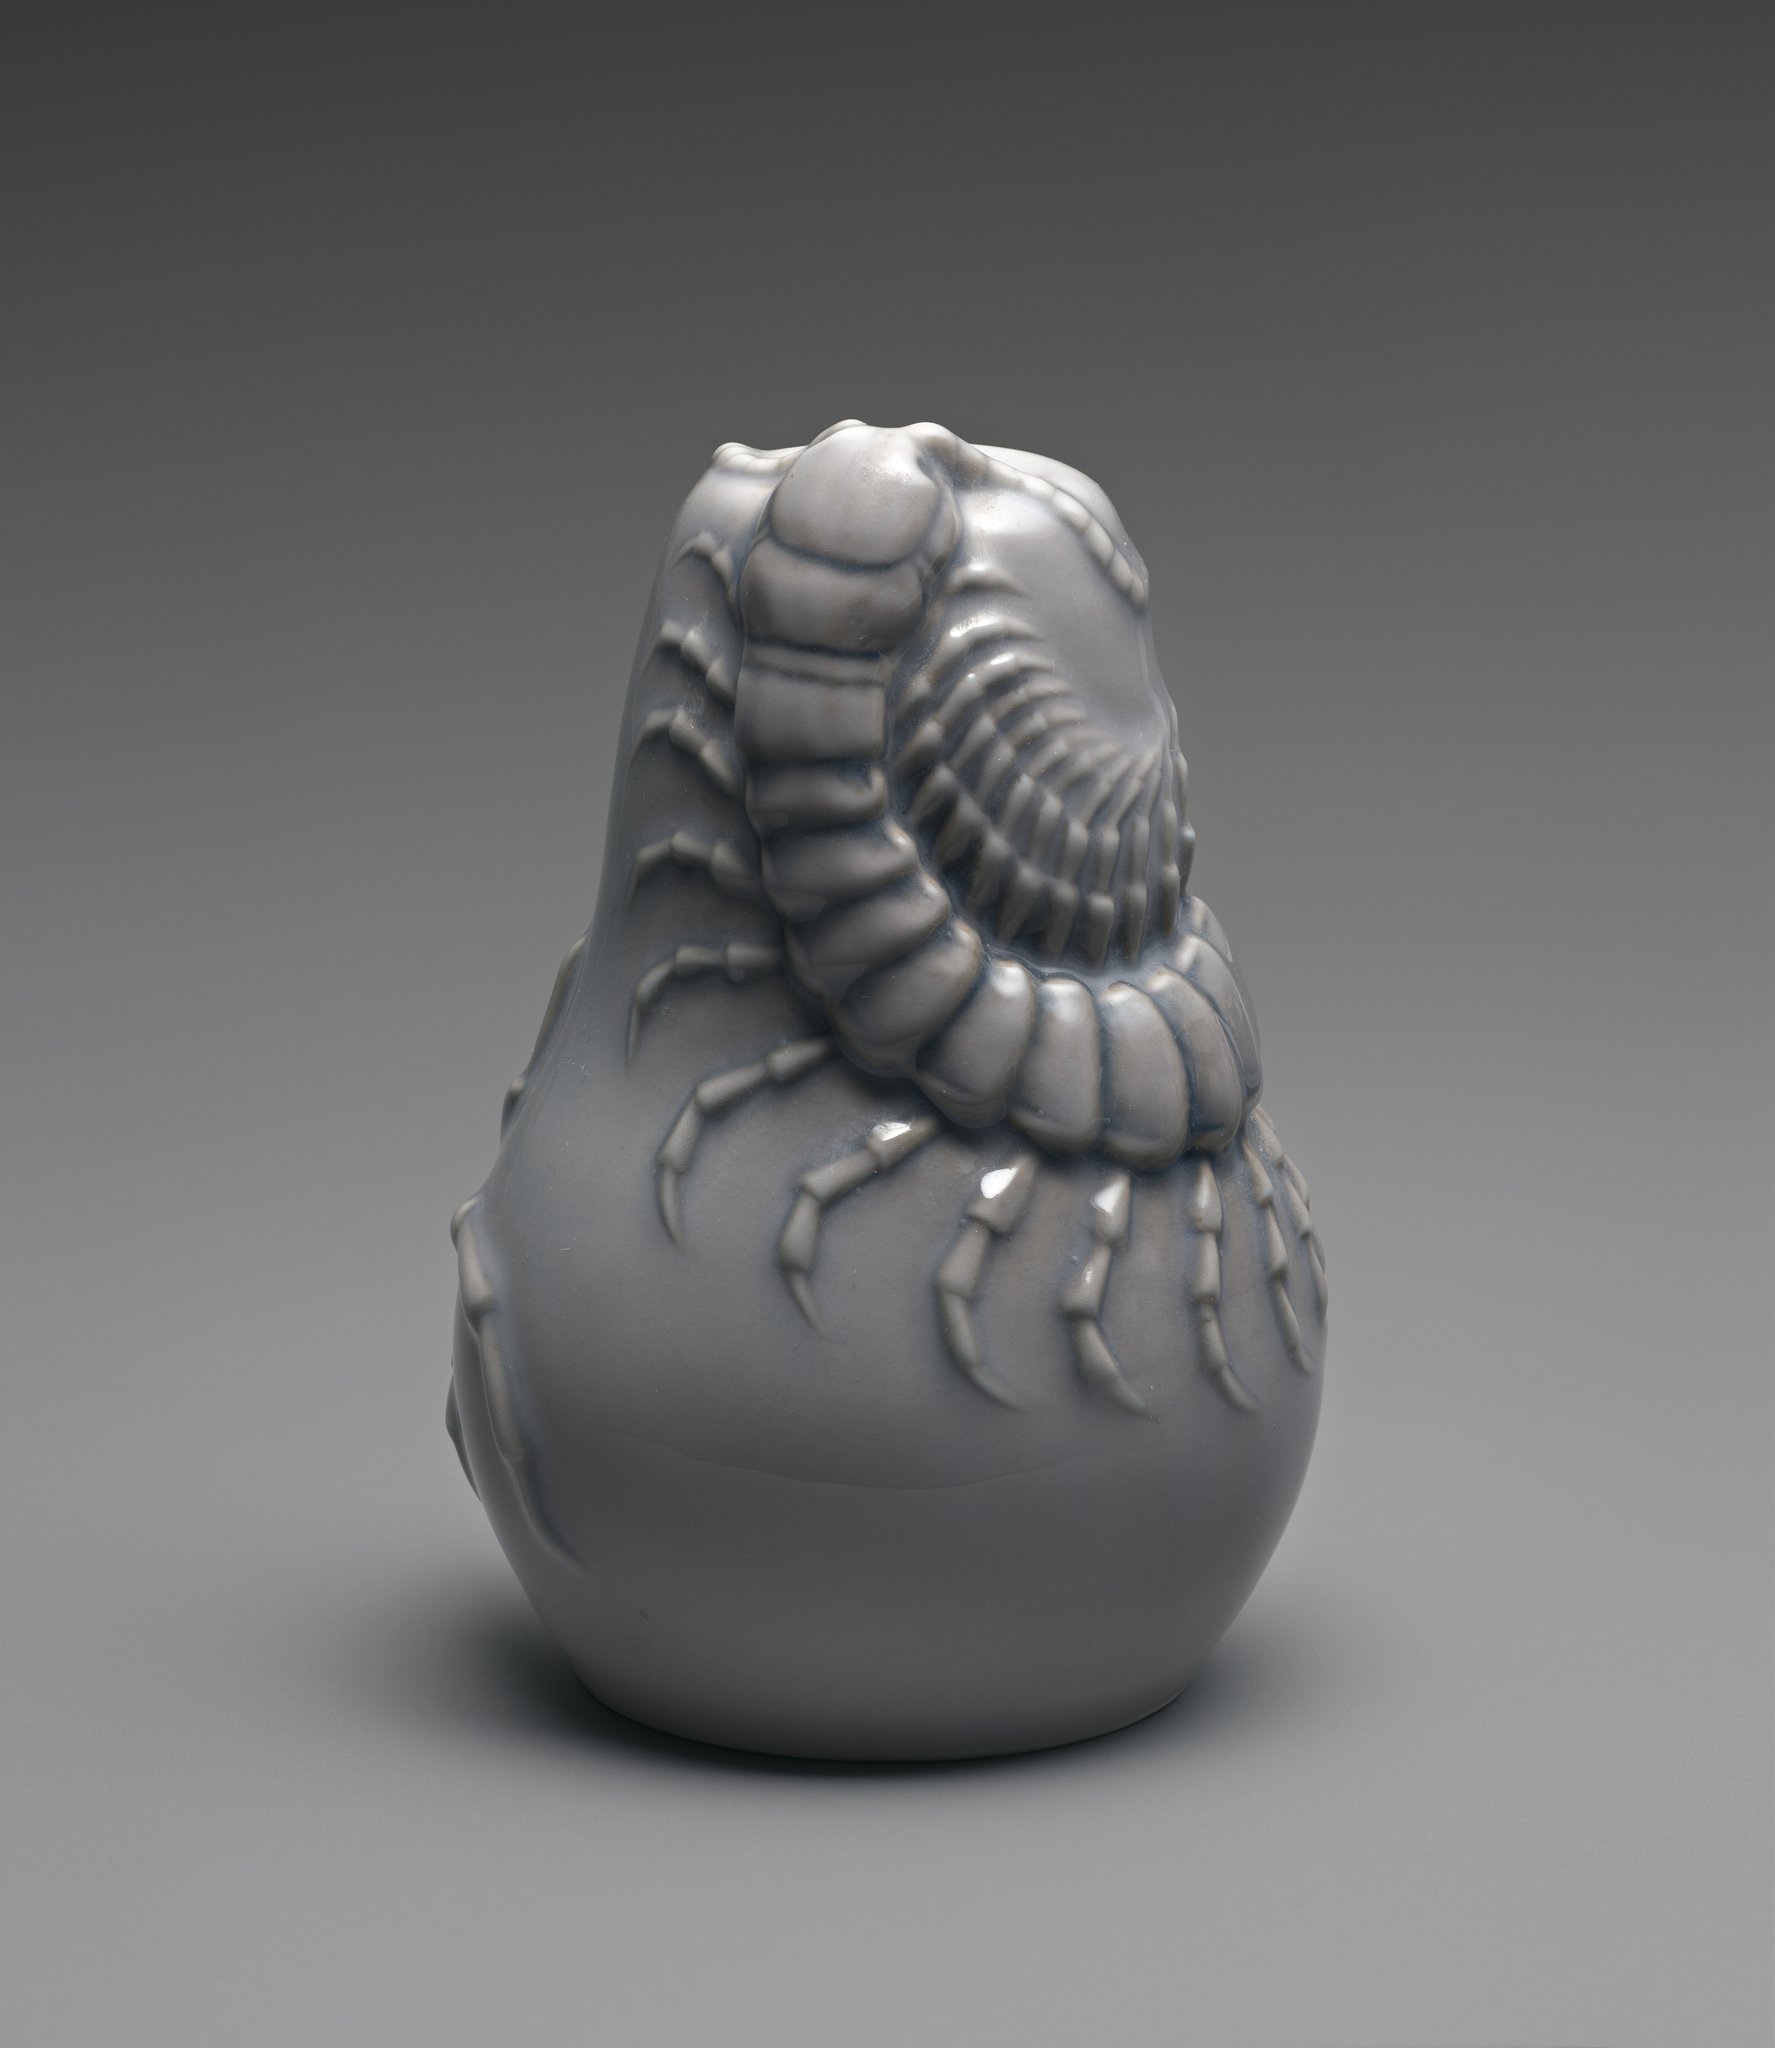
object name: vase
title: Vase with centipede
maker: royal copenhagen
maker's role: manufactory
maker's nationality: danish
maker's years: 1775-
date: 1900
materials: porcelain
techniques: glazing